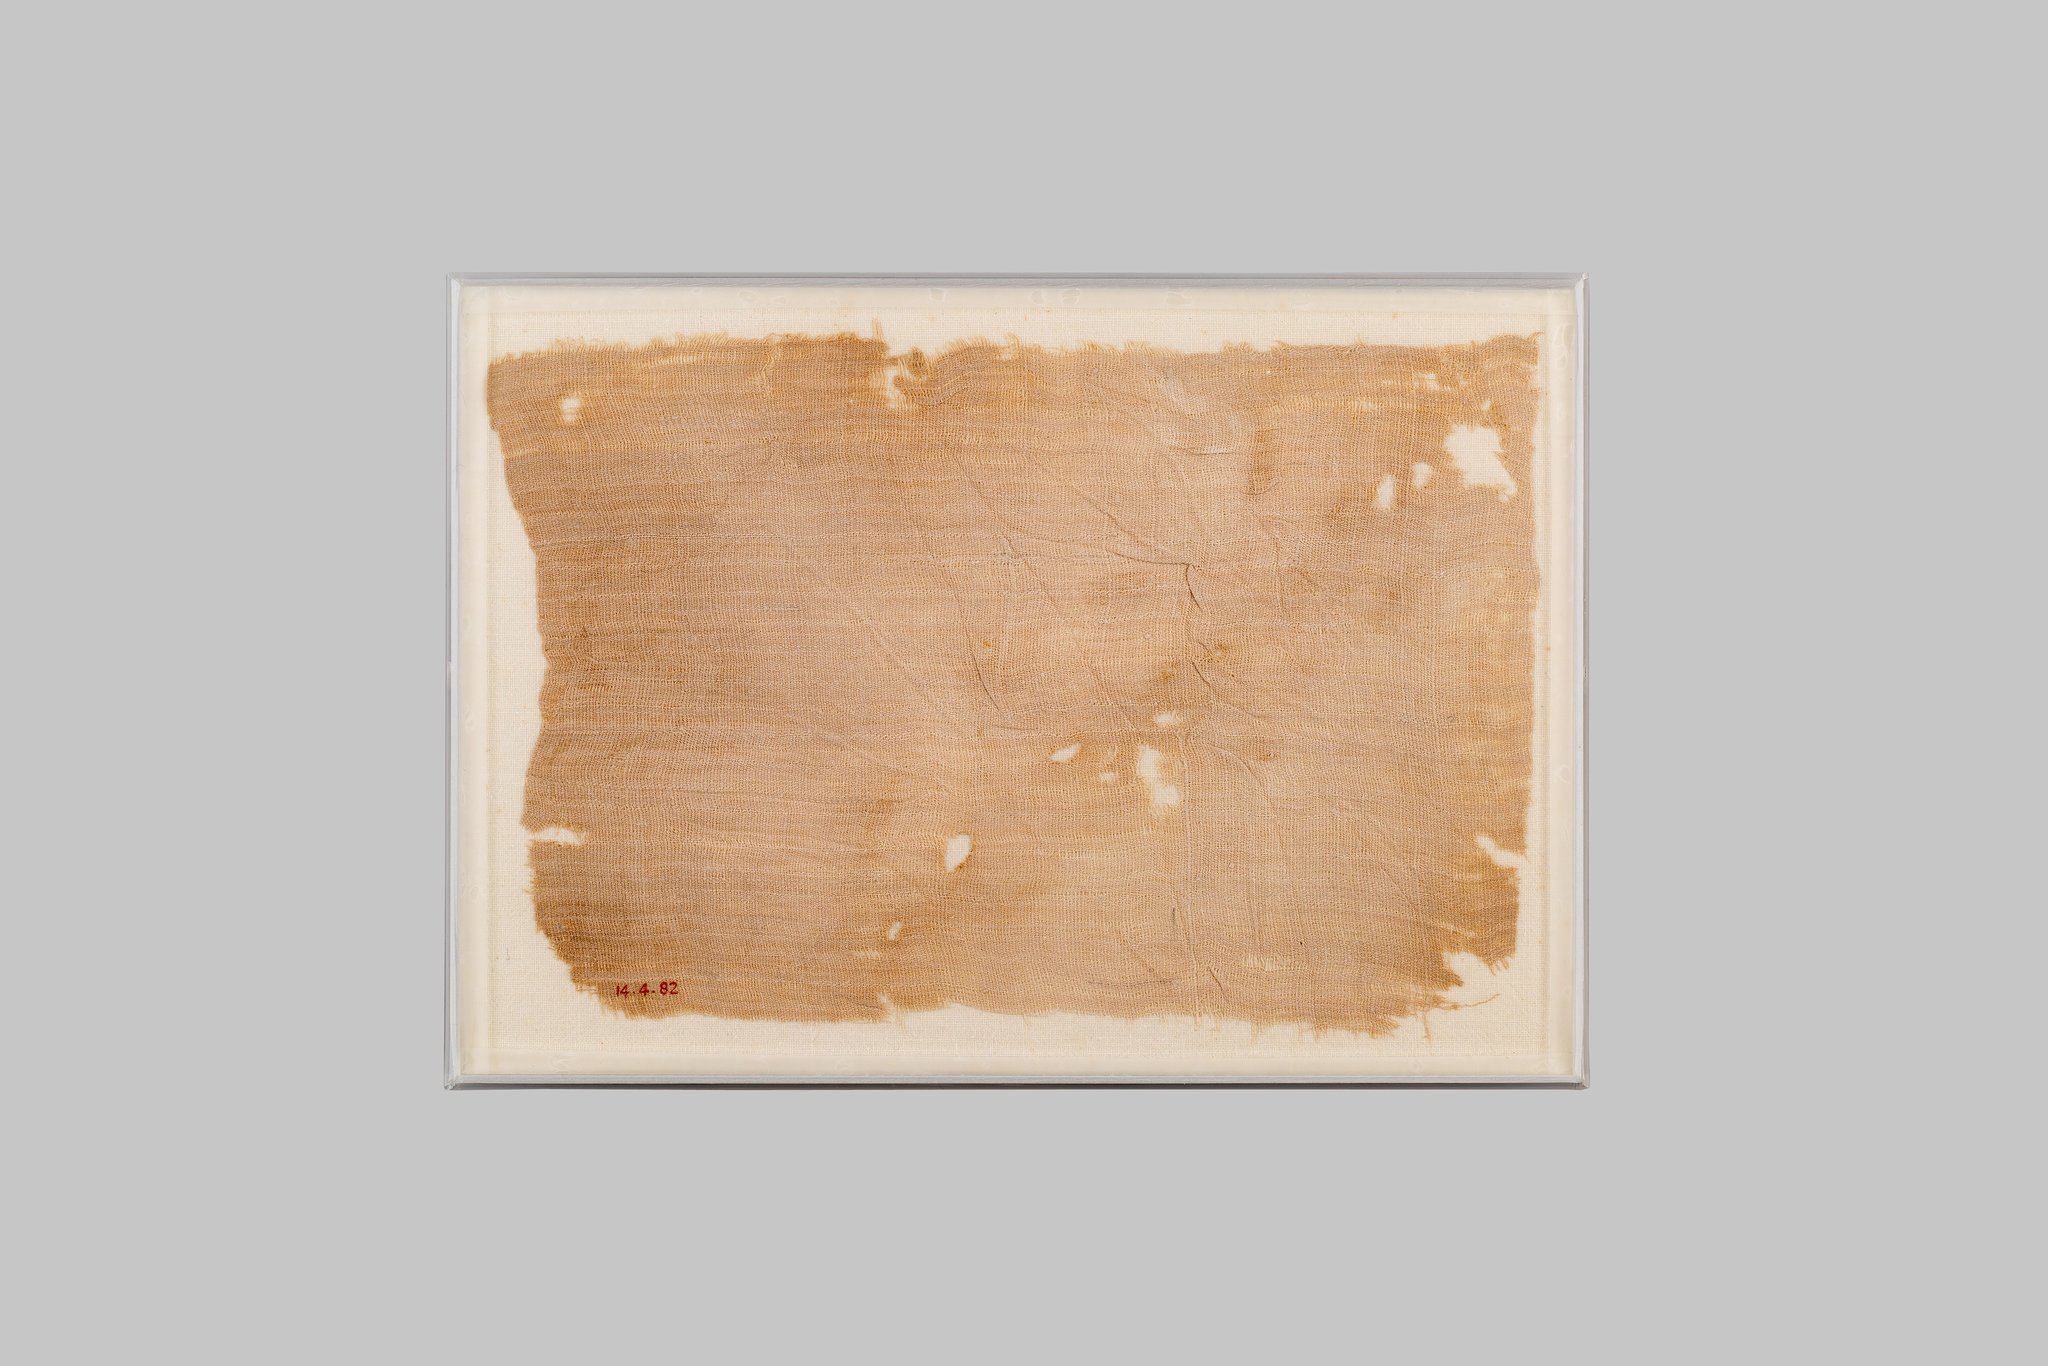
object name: linen fragment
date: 2880-2465 BCE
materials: linen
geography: egypt